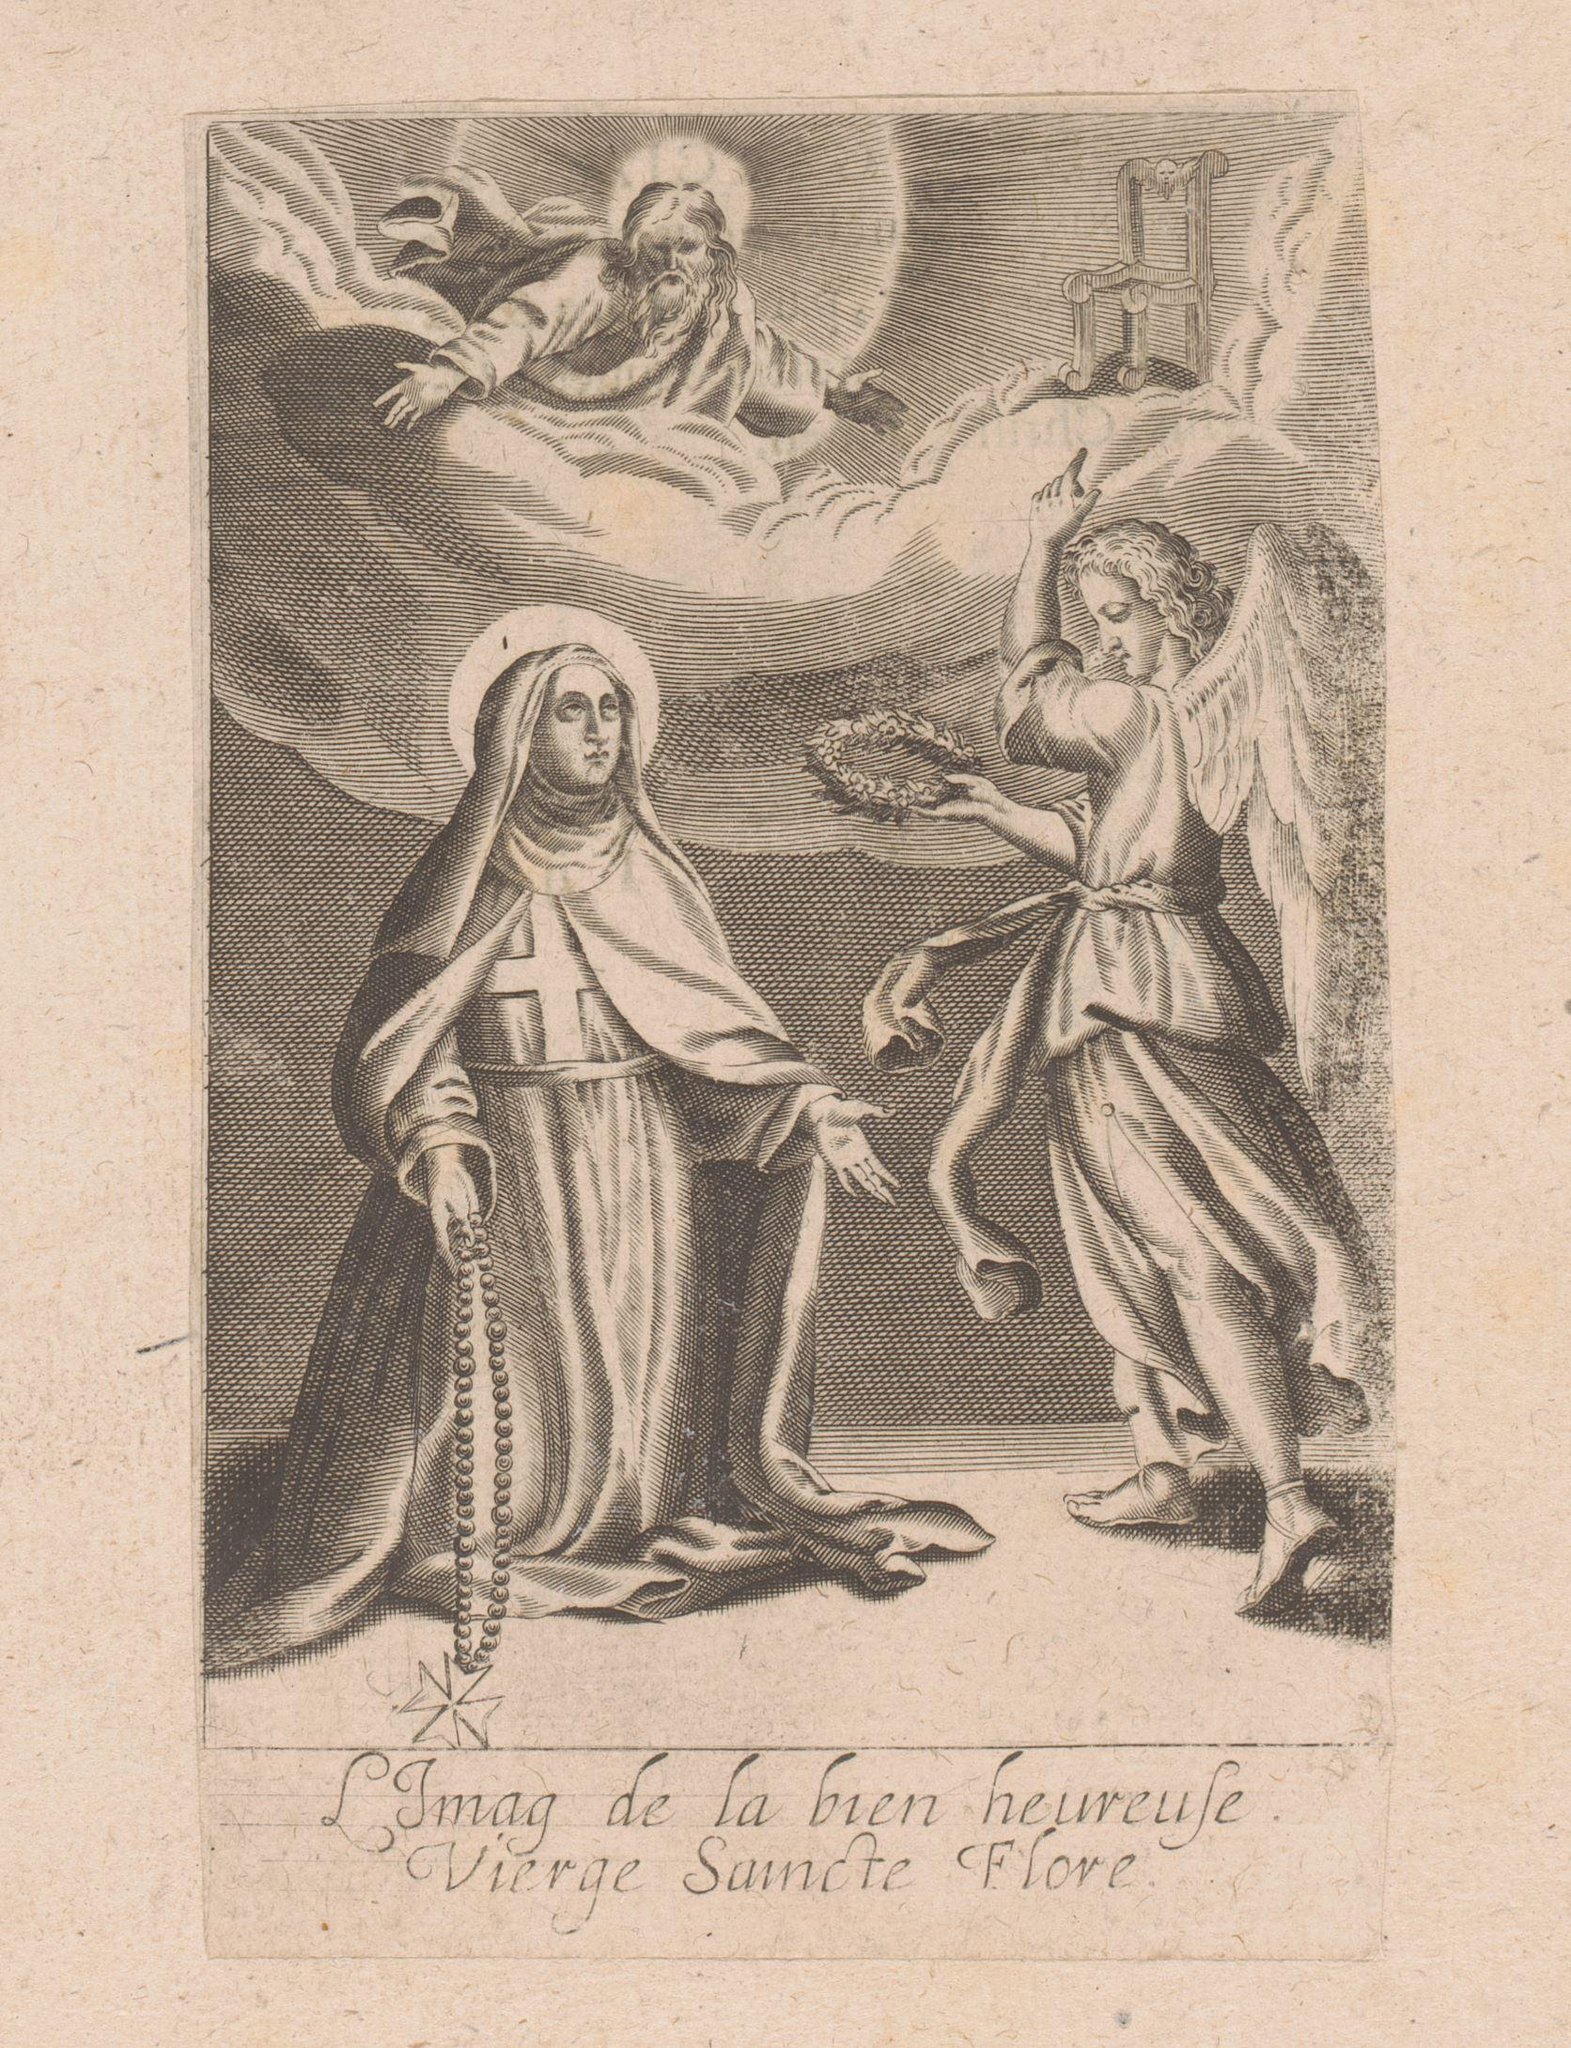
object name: book illustration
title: H. Flore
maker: Anonymous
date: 1600-1650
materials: paper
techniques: engraving, letterpress printing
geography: france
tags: female saints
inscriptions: collector's mark: Lugt 2228